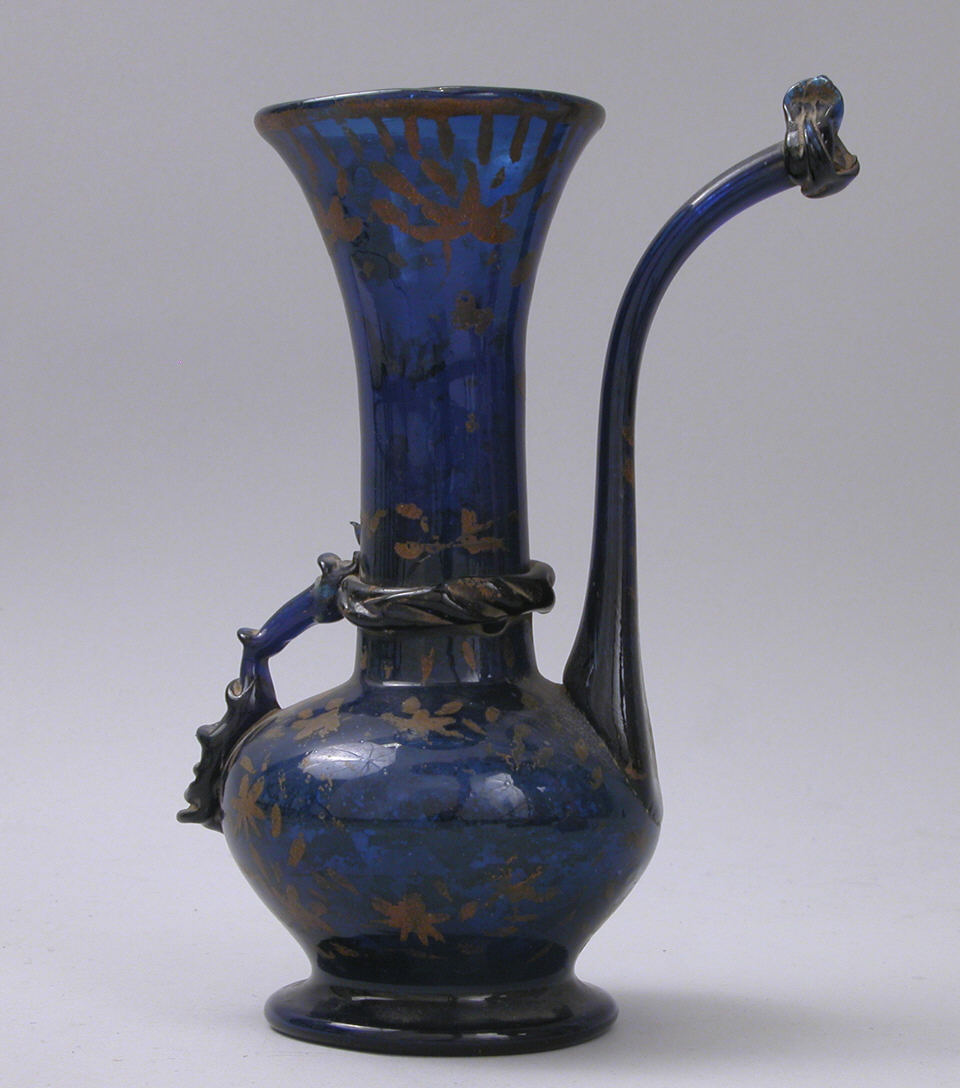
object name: ewer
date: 1701-1900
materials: glass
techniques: glassblowing, painting, tooling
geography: iran